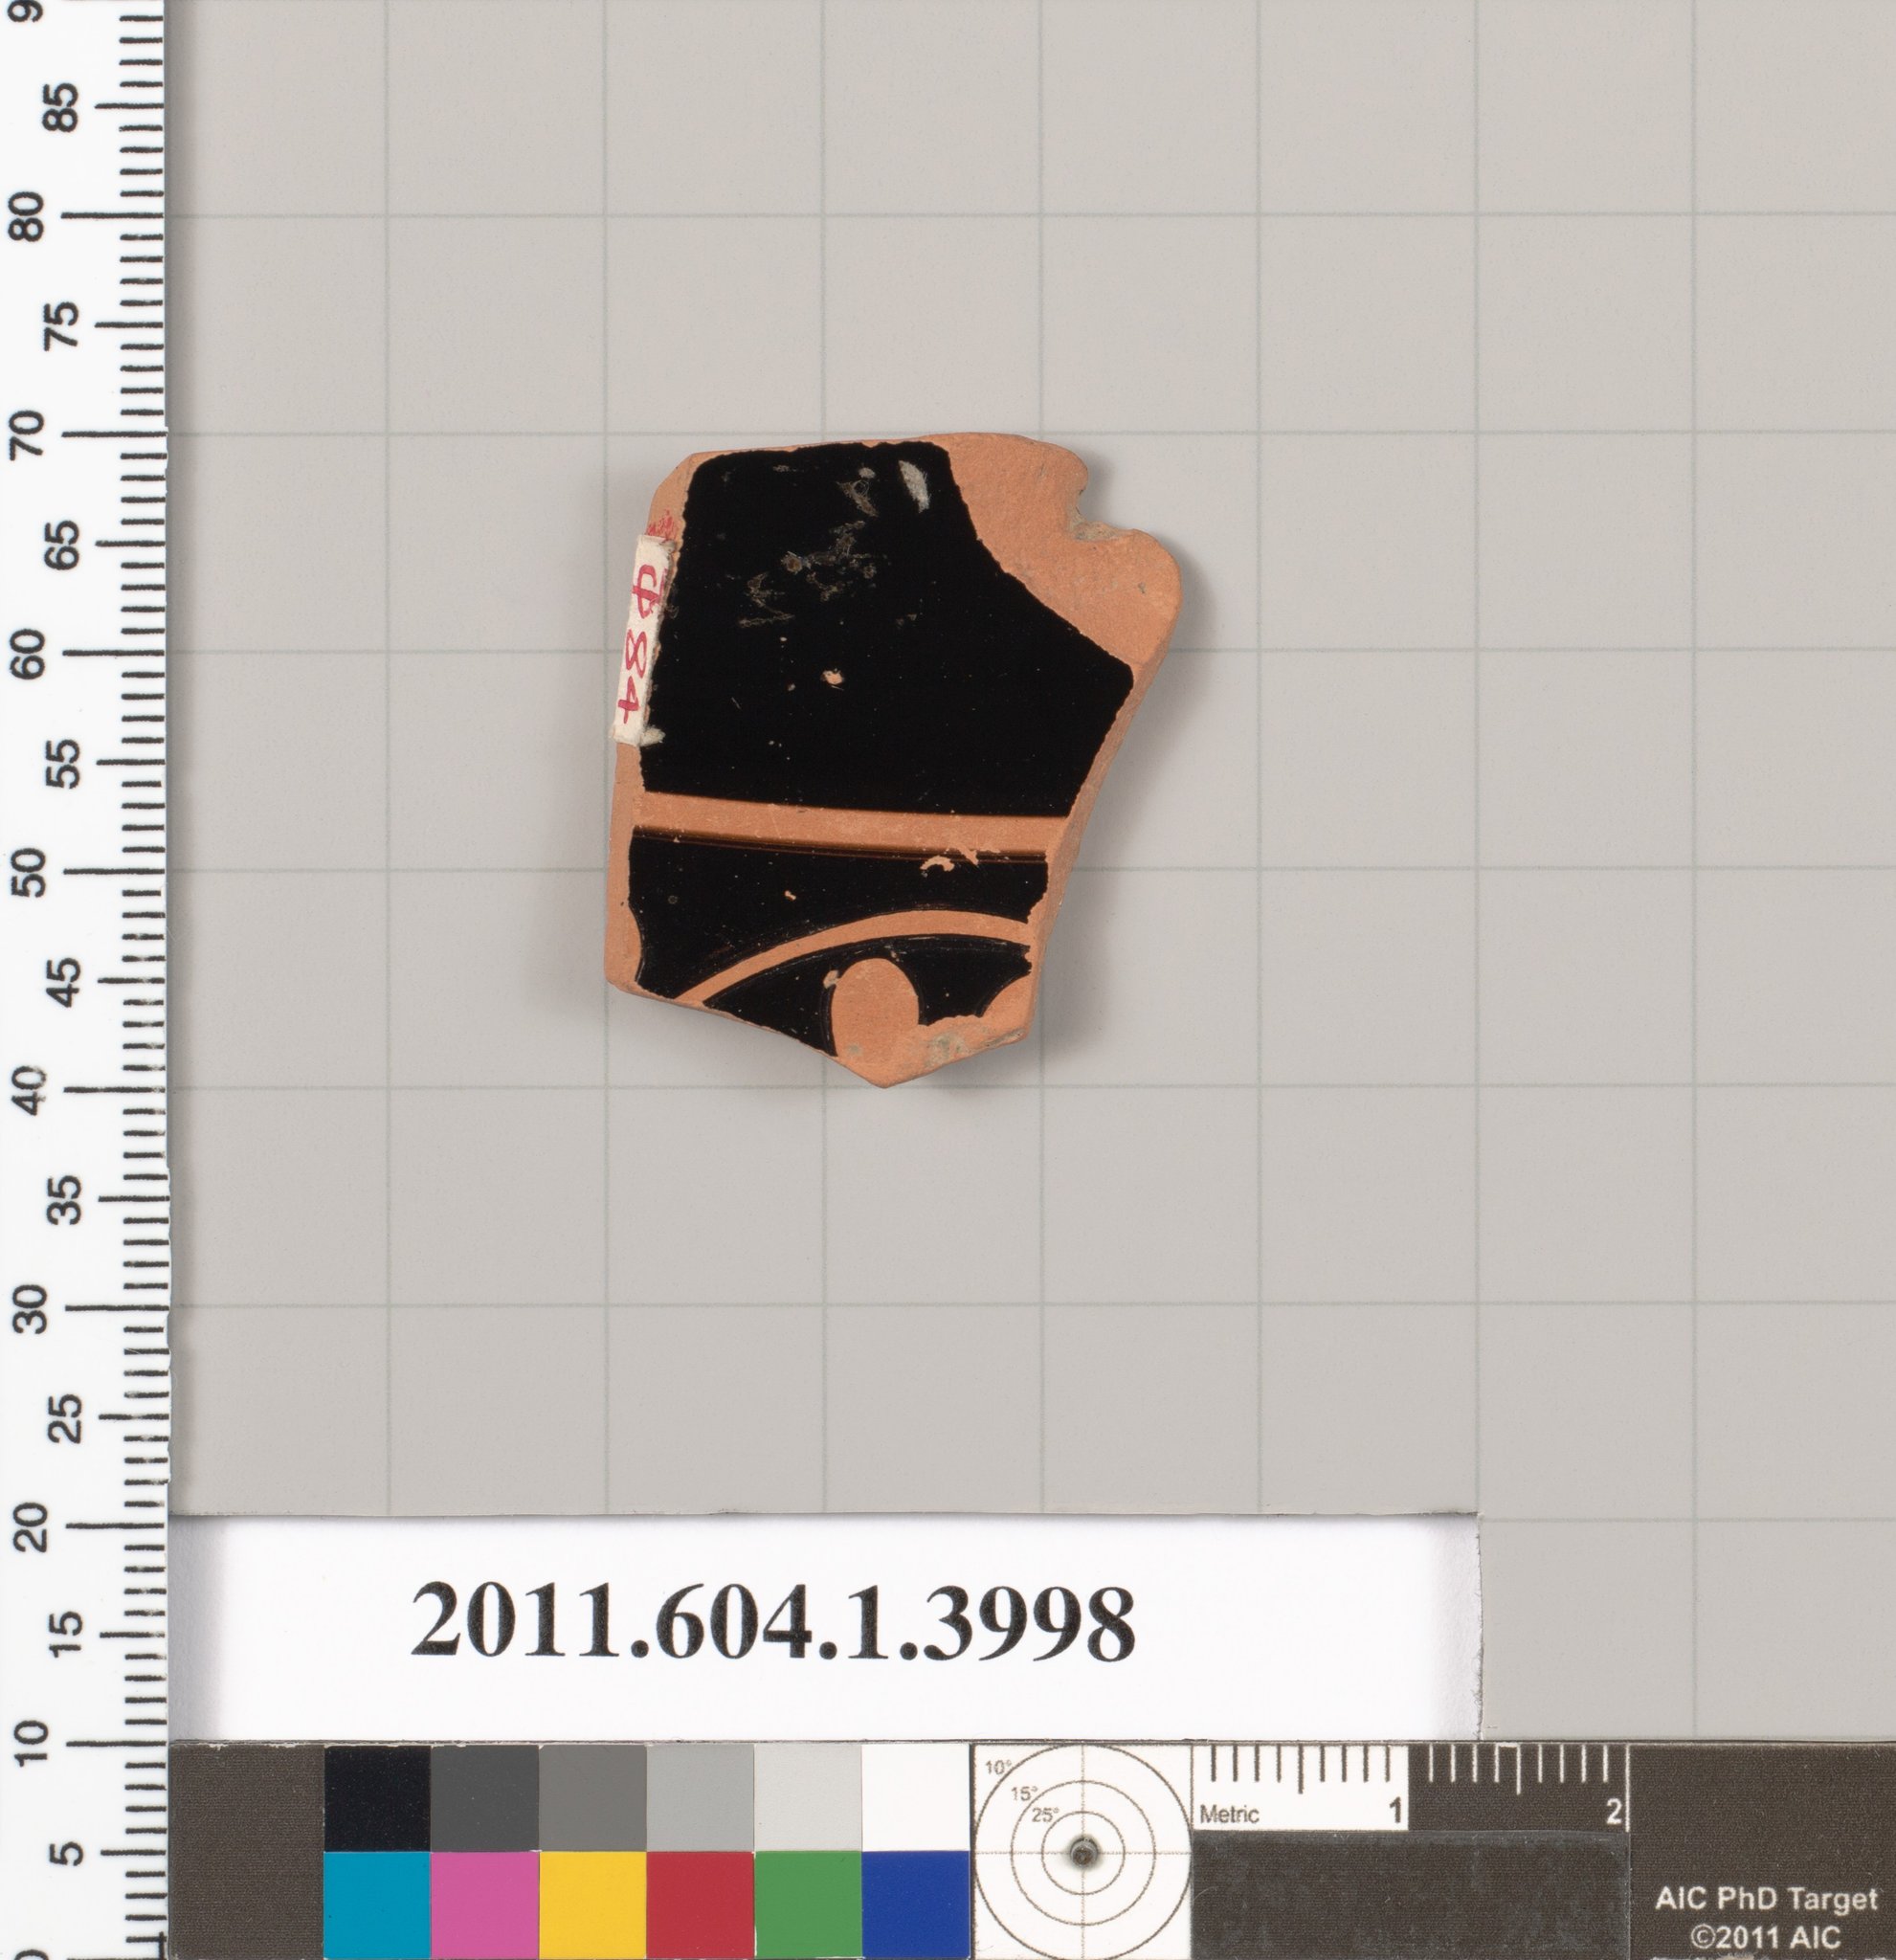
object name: kylix fragment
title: Terracotta fragment of a kylix (drinking cup)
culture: greek, attic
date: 510-490 BCE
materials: terracotta